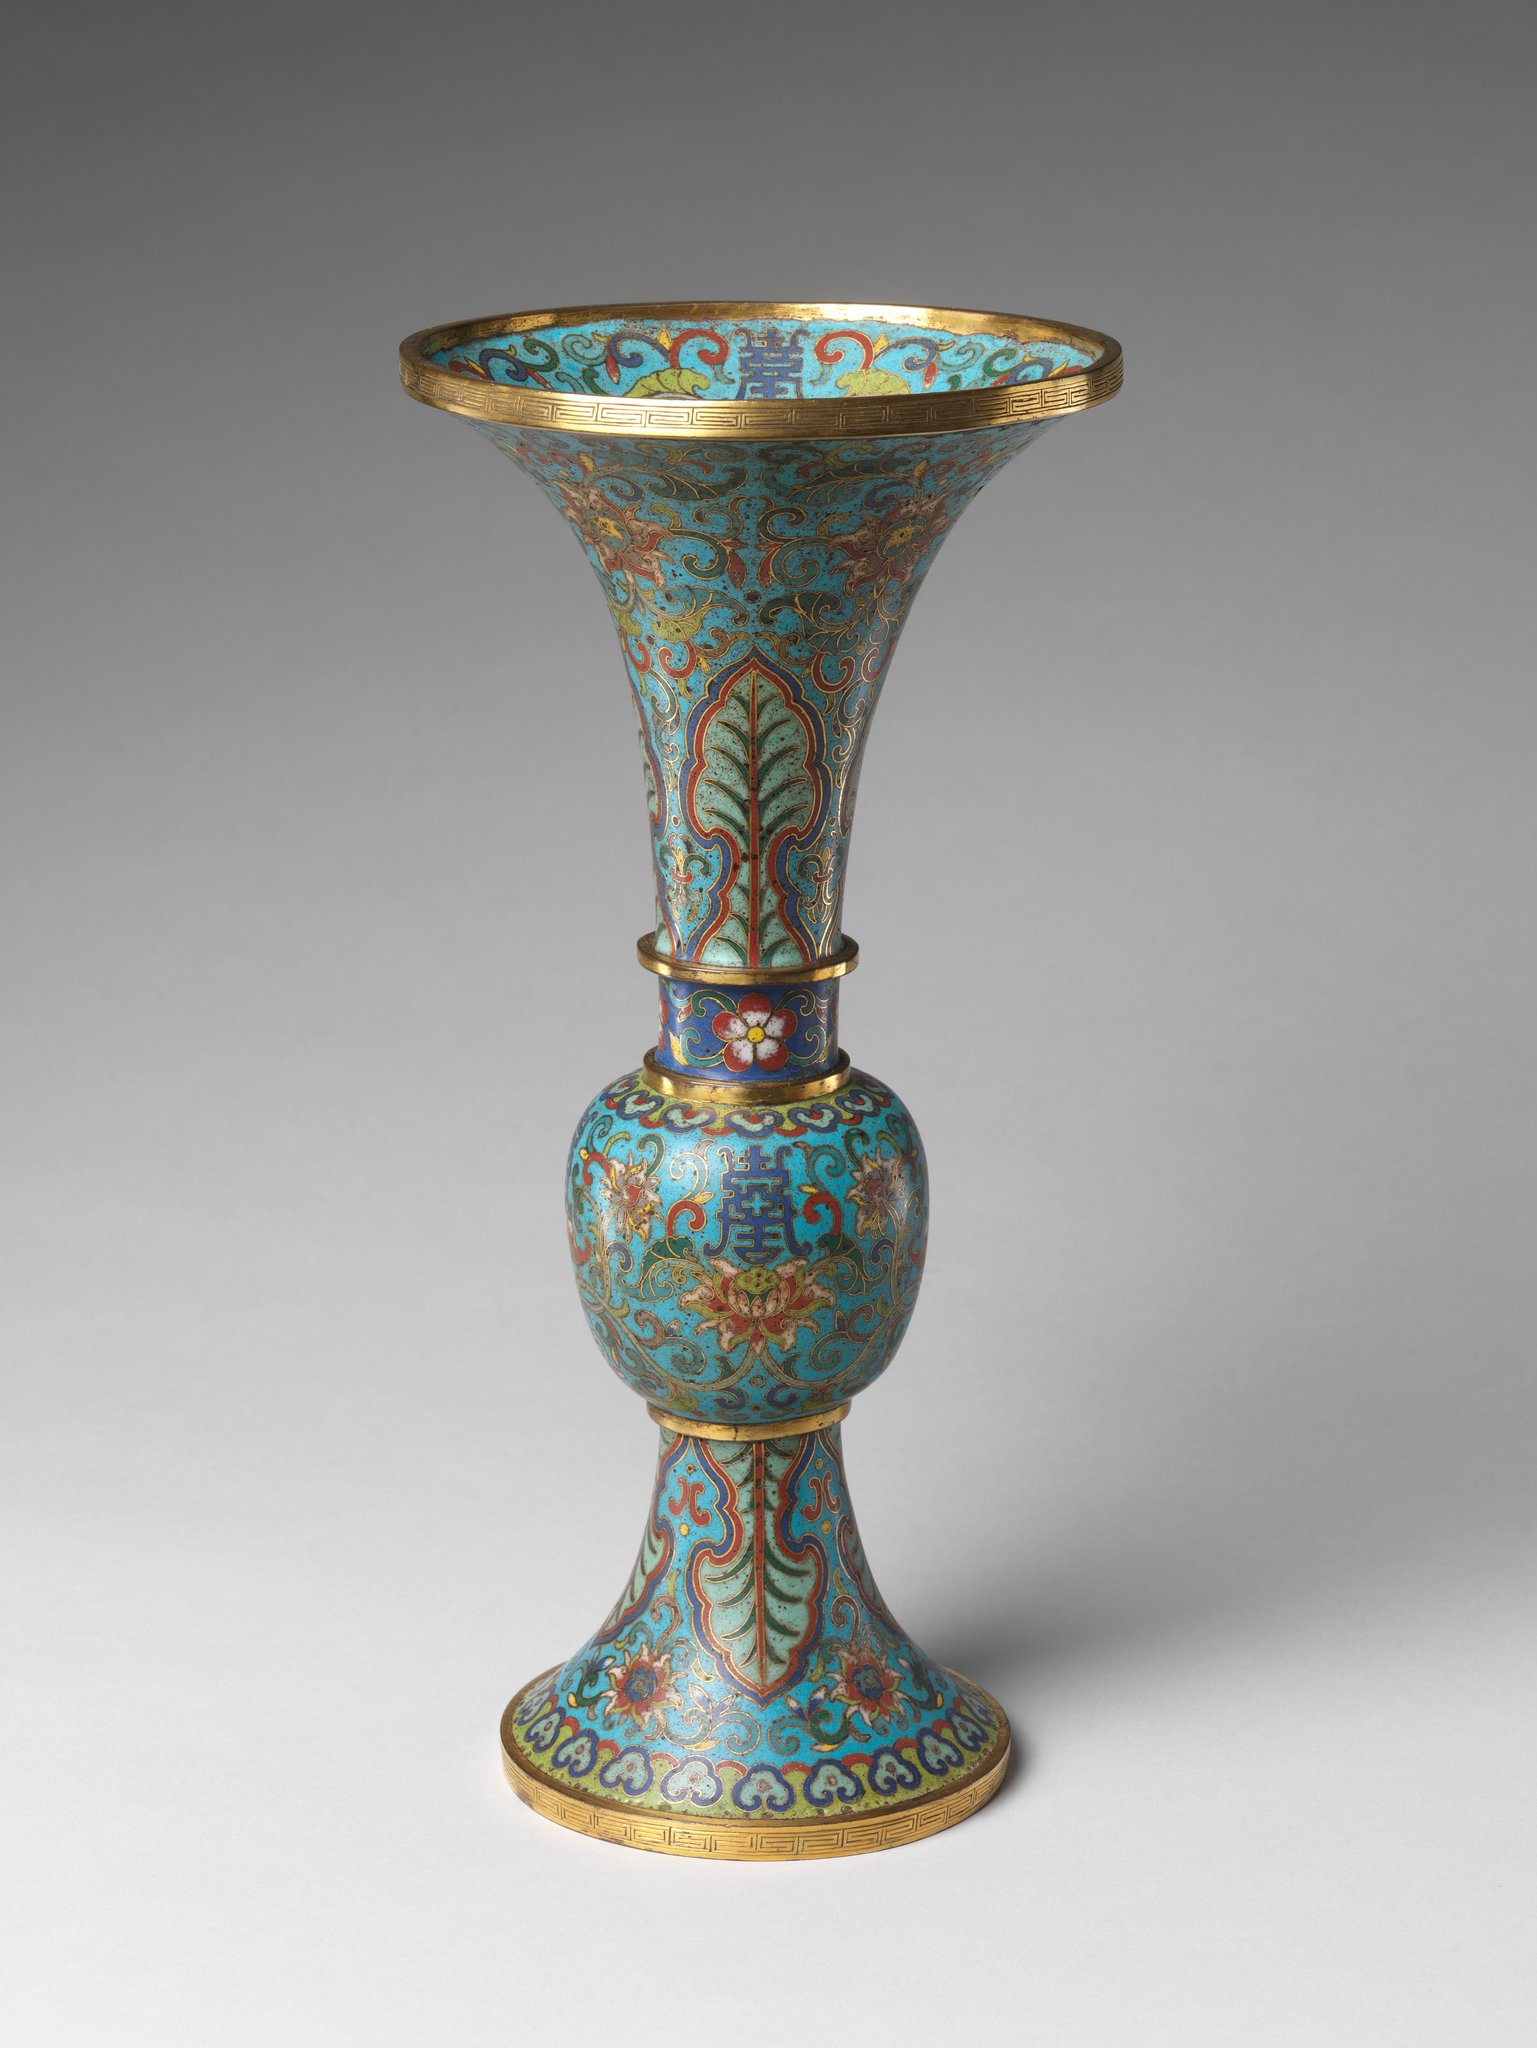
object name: vase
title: Vase from a five-piece altar set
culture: chinese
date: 1751-1800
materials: enamel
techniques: enamel